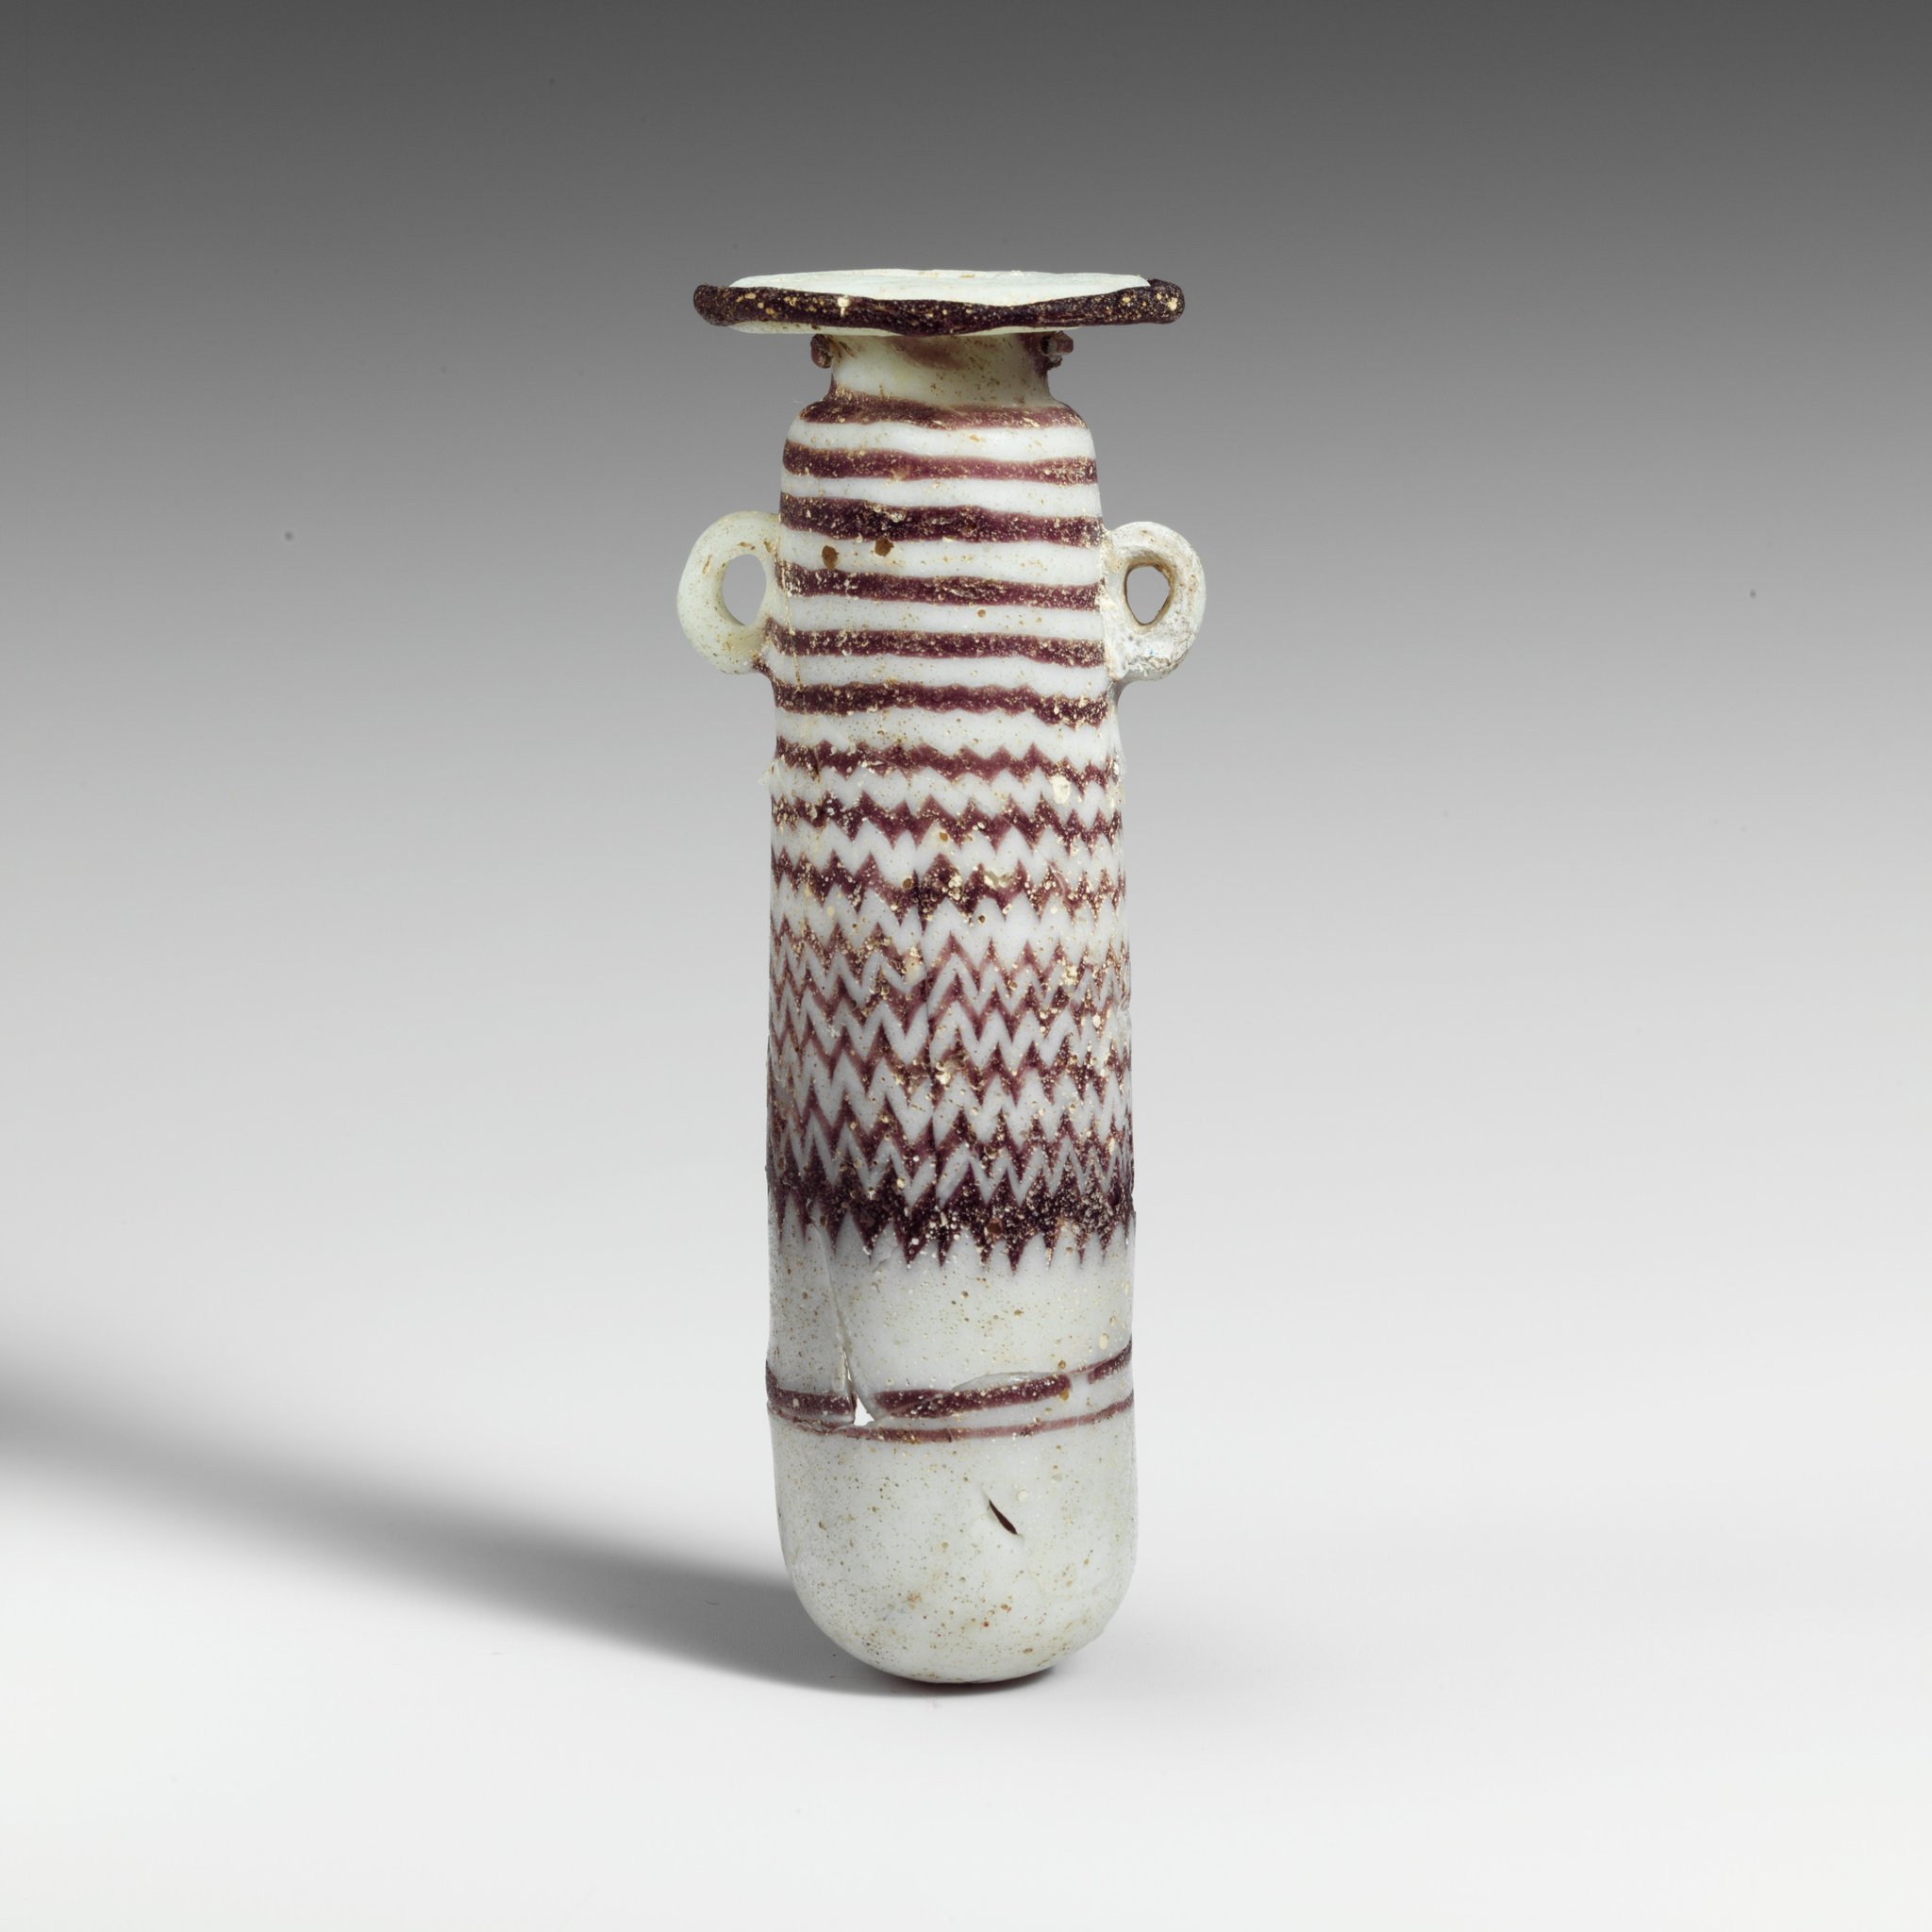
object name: alabastron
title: Glass alabastron (perfume bottle)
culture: greek, eastern mediterranean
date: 534-401 BCE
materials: glass